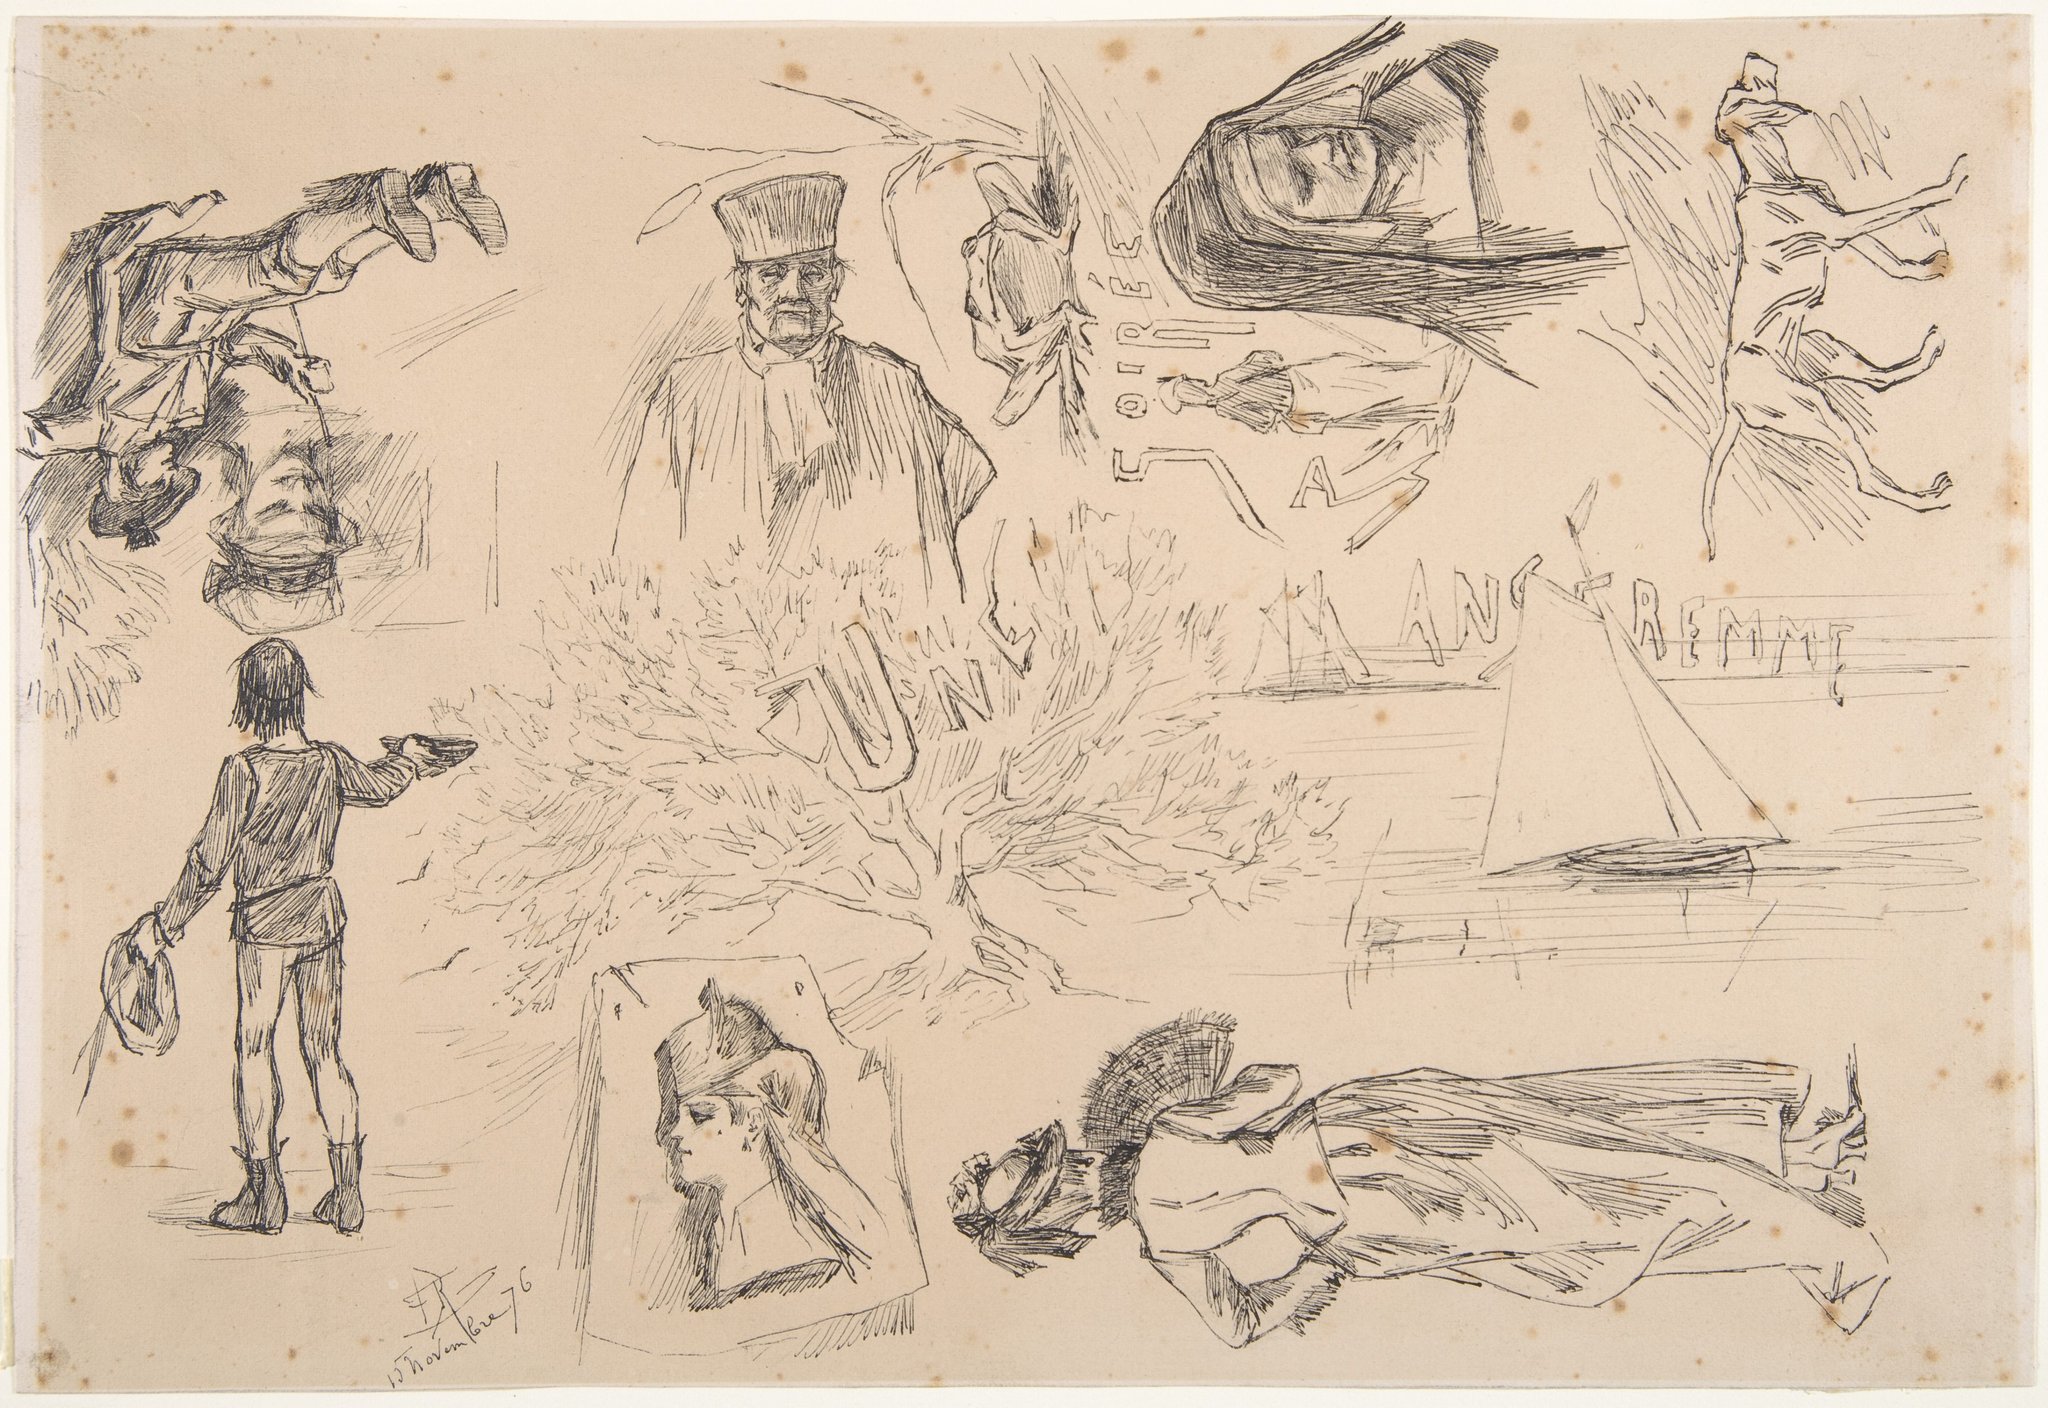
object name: drawing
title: Une Soirée Anseremme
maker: félicien rops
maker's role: artist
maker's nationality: belgian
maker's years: 1833-1898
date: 1876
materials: ink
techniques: pen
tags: men,profiles,women,dogs,boats